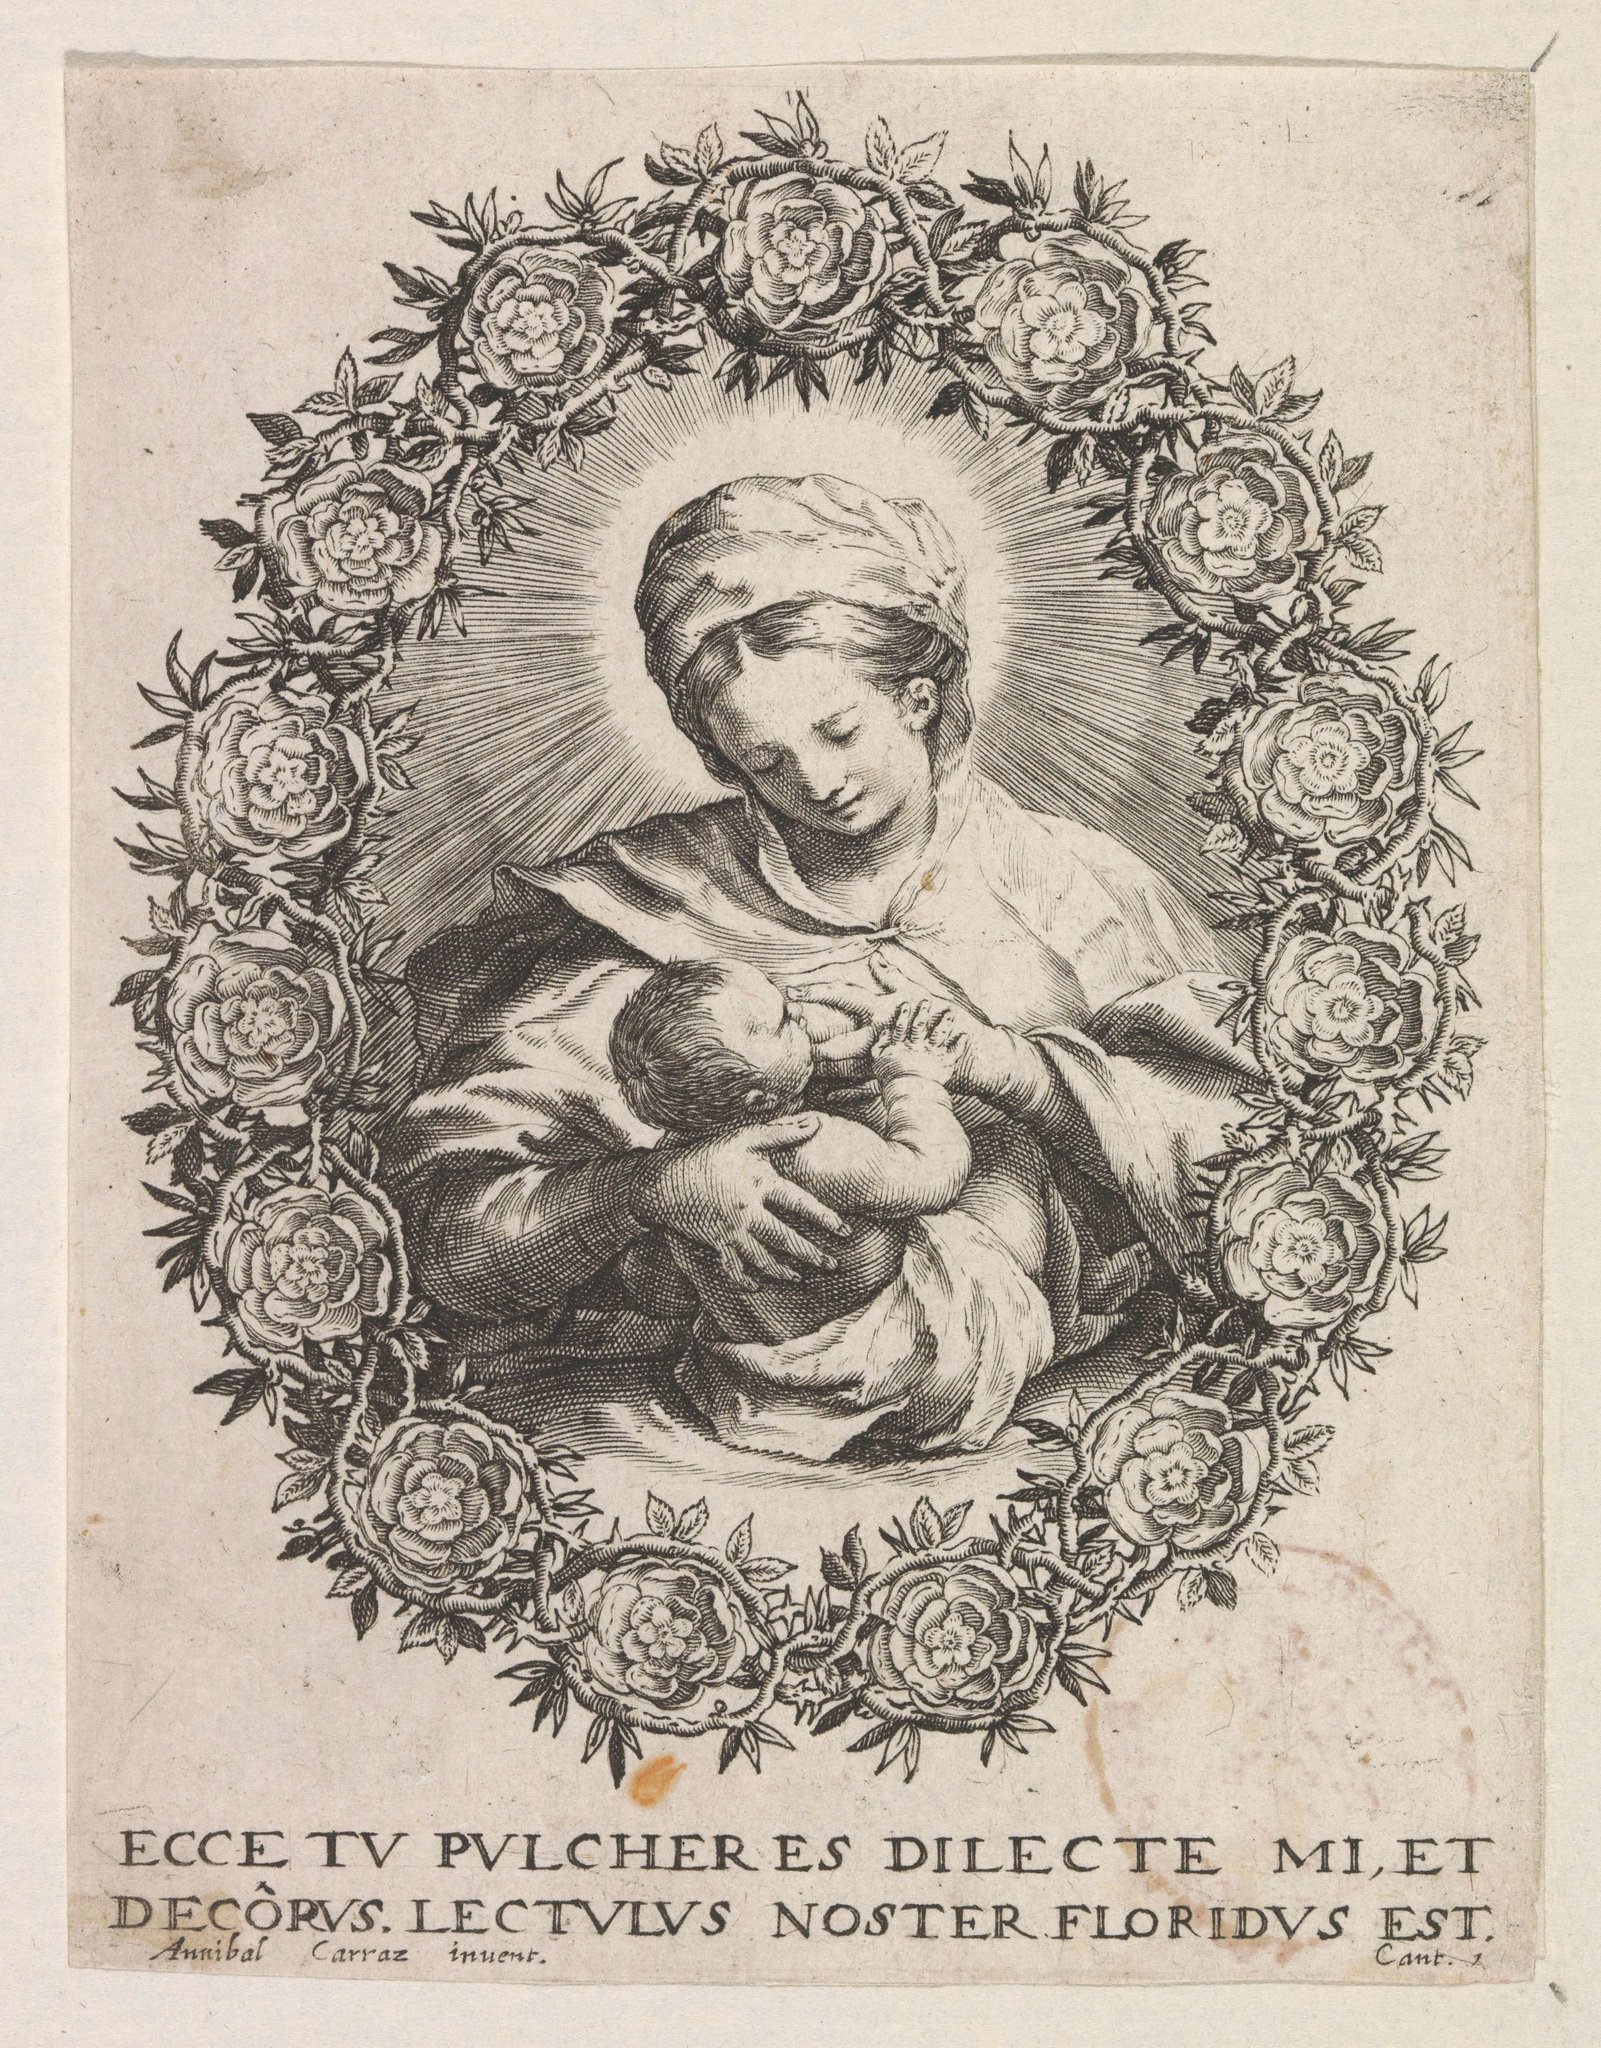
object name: print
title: Maria zoogt het Christuskind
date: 1570-1678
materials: paper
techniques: engraving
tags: christ-child suckling, or beginning to suckle, e.g. mary uncovering her breast ~ madonna-representations, flowers: rose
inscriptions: collector's mark: Lugt 240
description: De maagd Maria zoogt het Christuskind. Rondom hen een krans van rozen.